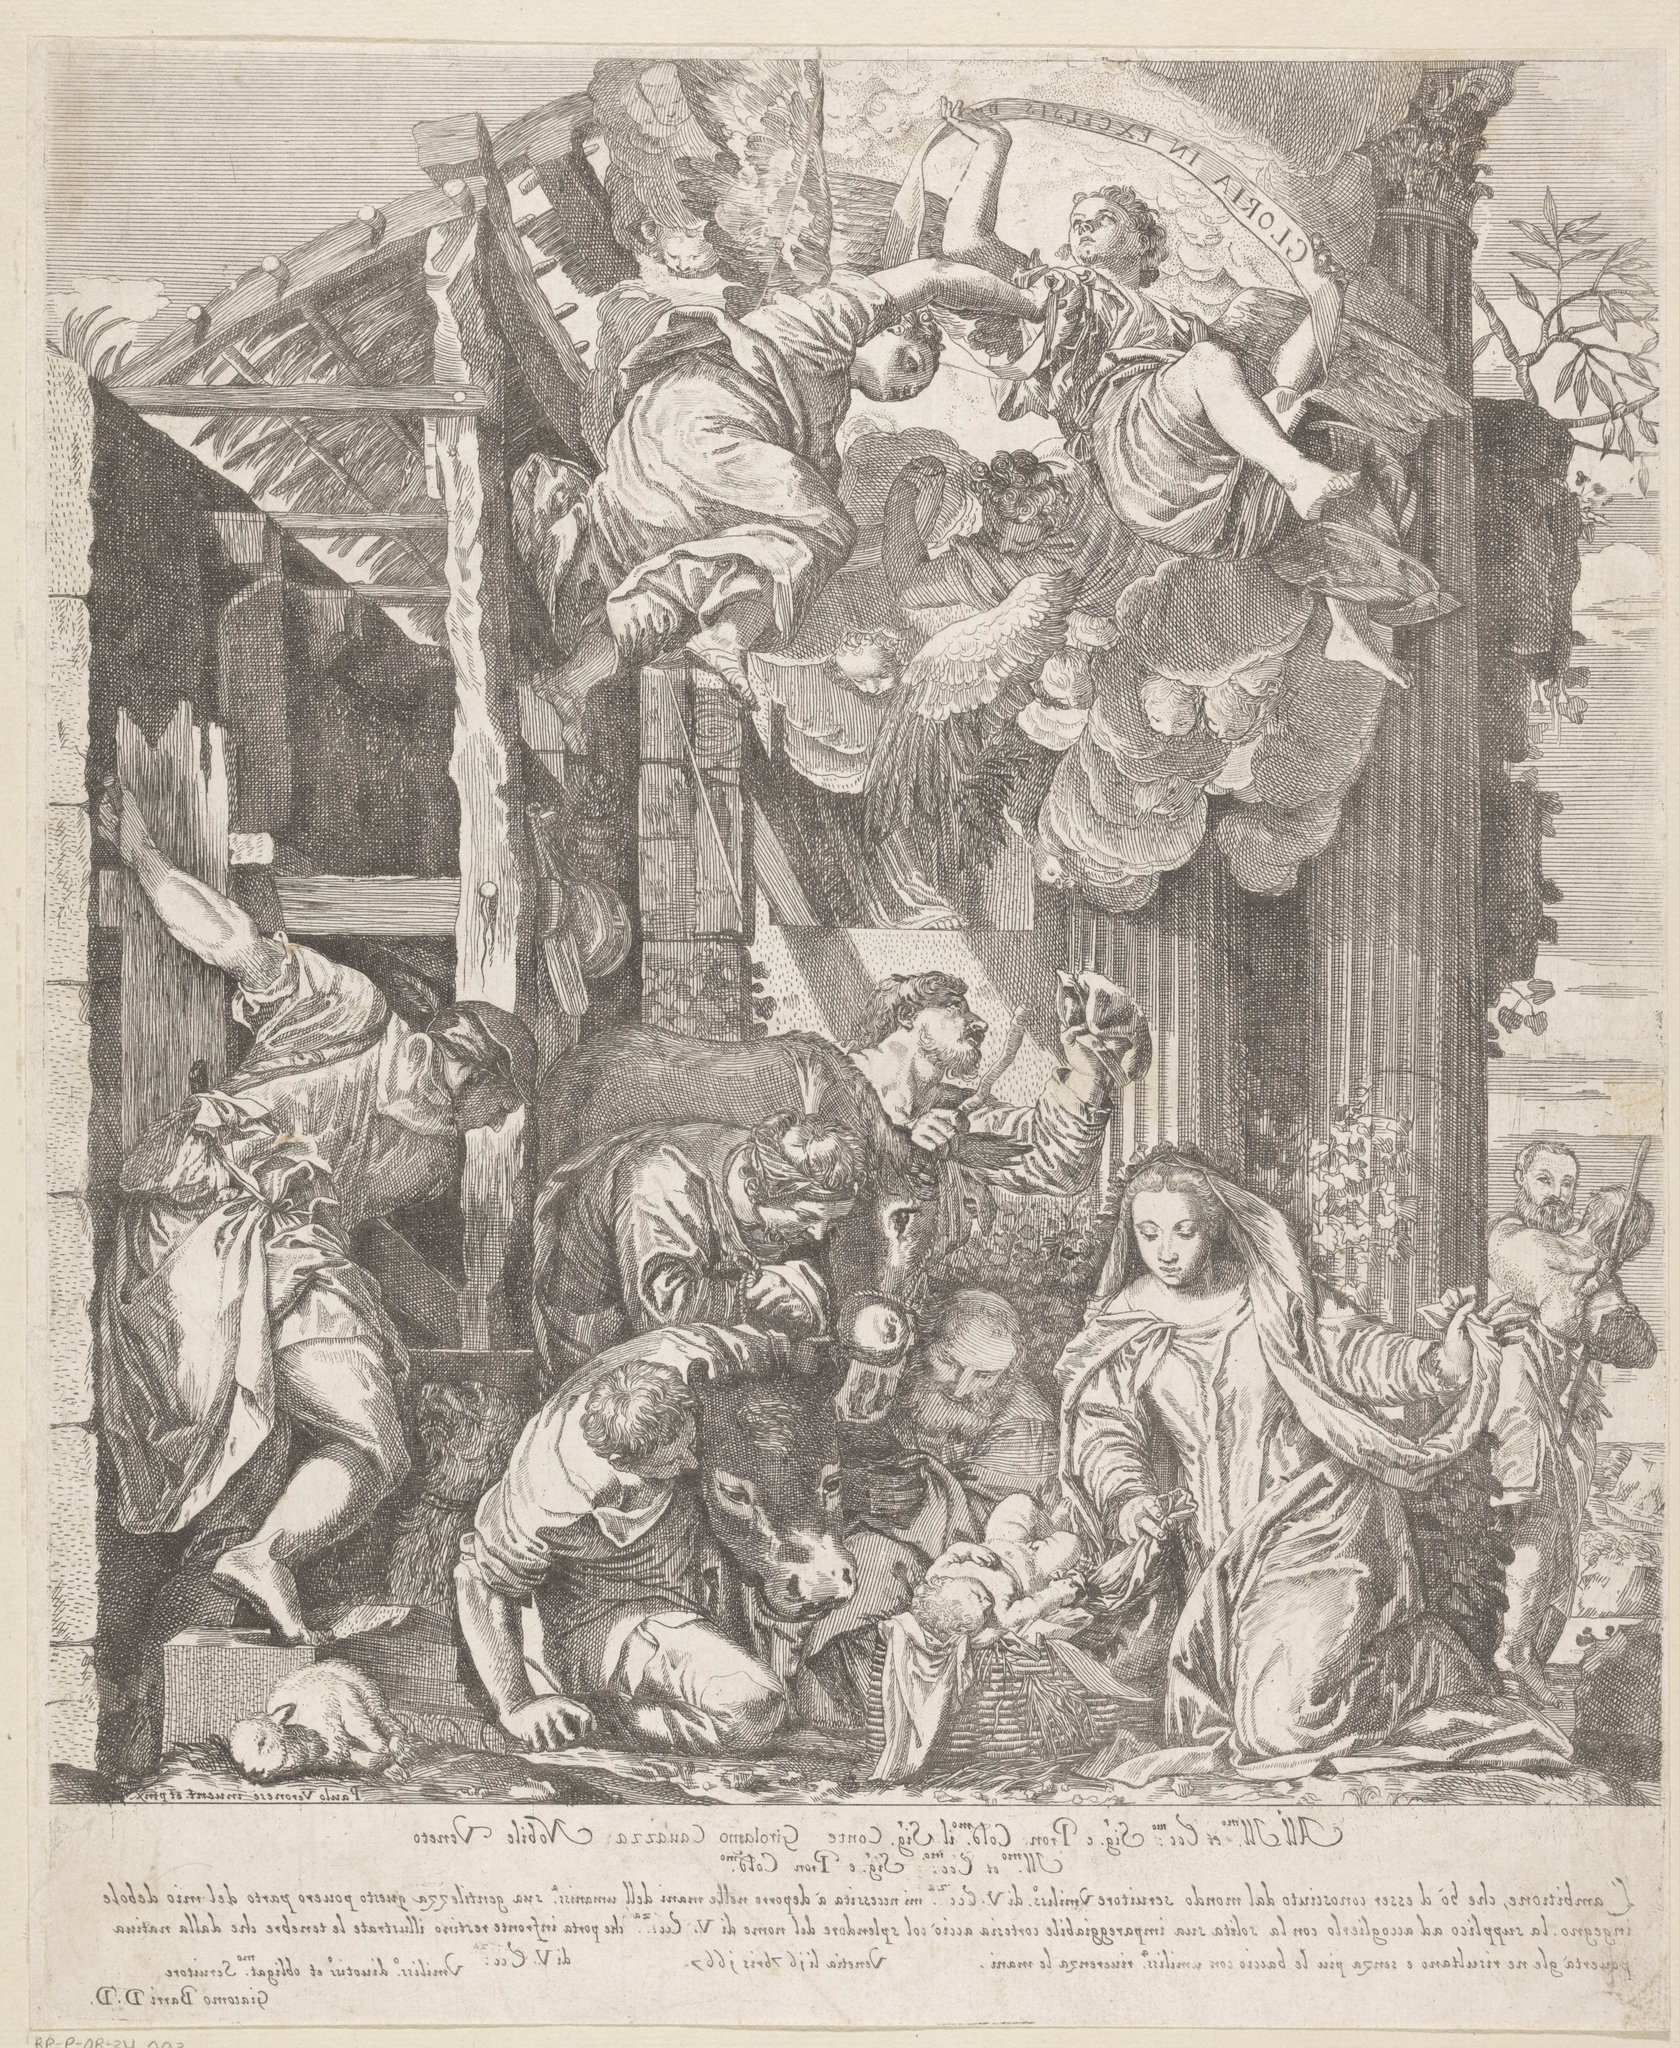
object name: print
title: Aanbidding door de herders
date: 1667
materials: paper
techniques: printmaking, etching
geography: rome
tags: adoration of the christ-child by the shepherds; mary and joseph present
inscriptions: collector's mark: Lugt 240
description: Onder het dak van een oude houten stal, zit Maria geknield en toont het Christuskind in de kribbe aan een groep herders. Met de os en de ezel. In de lucht engelen, van wie er een een banderol met de tekst: Gloria in excelsis D[eo] in de handen houdt.